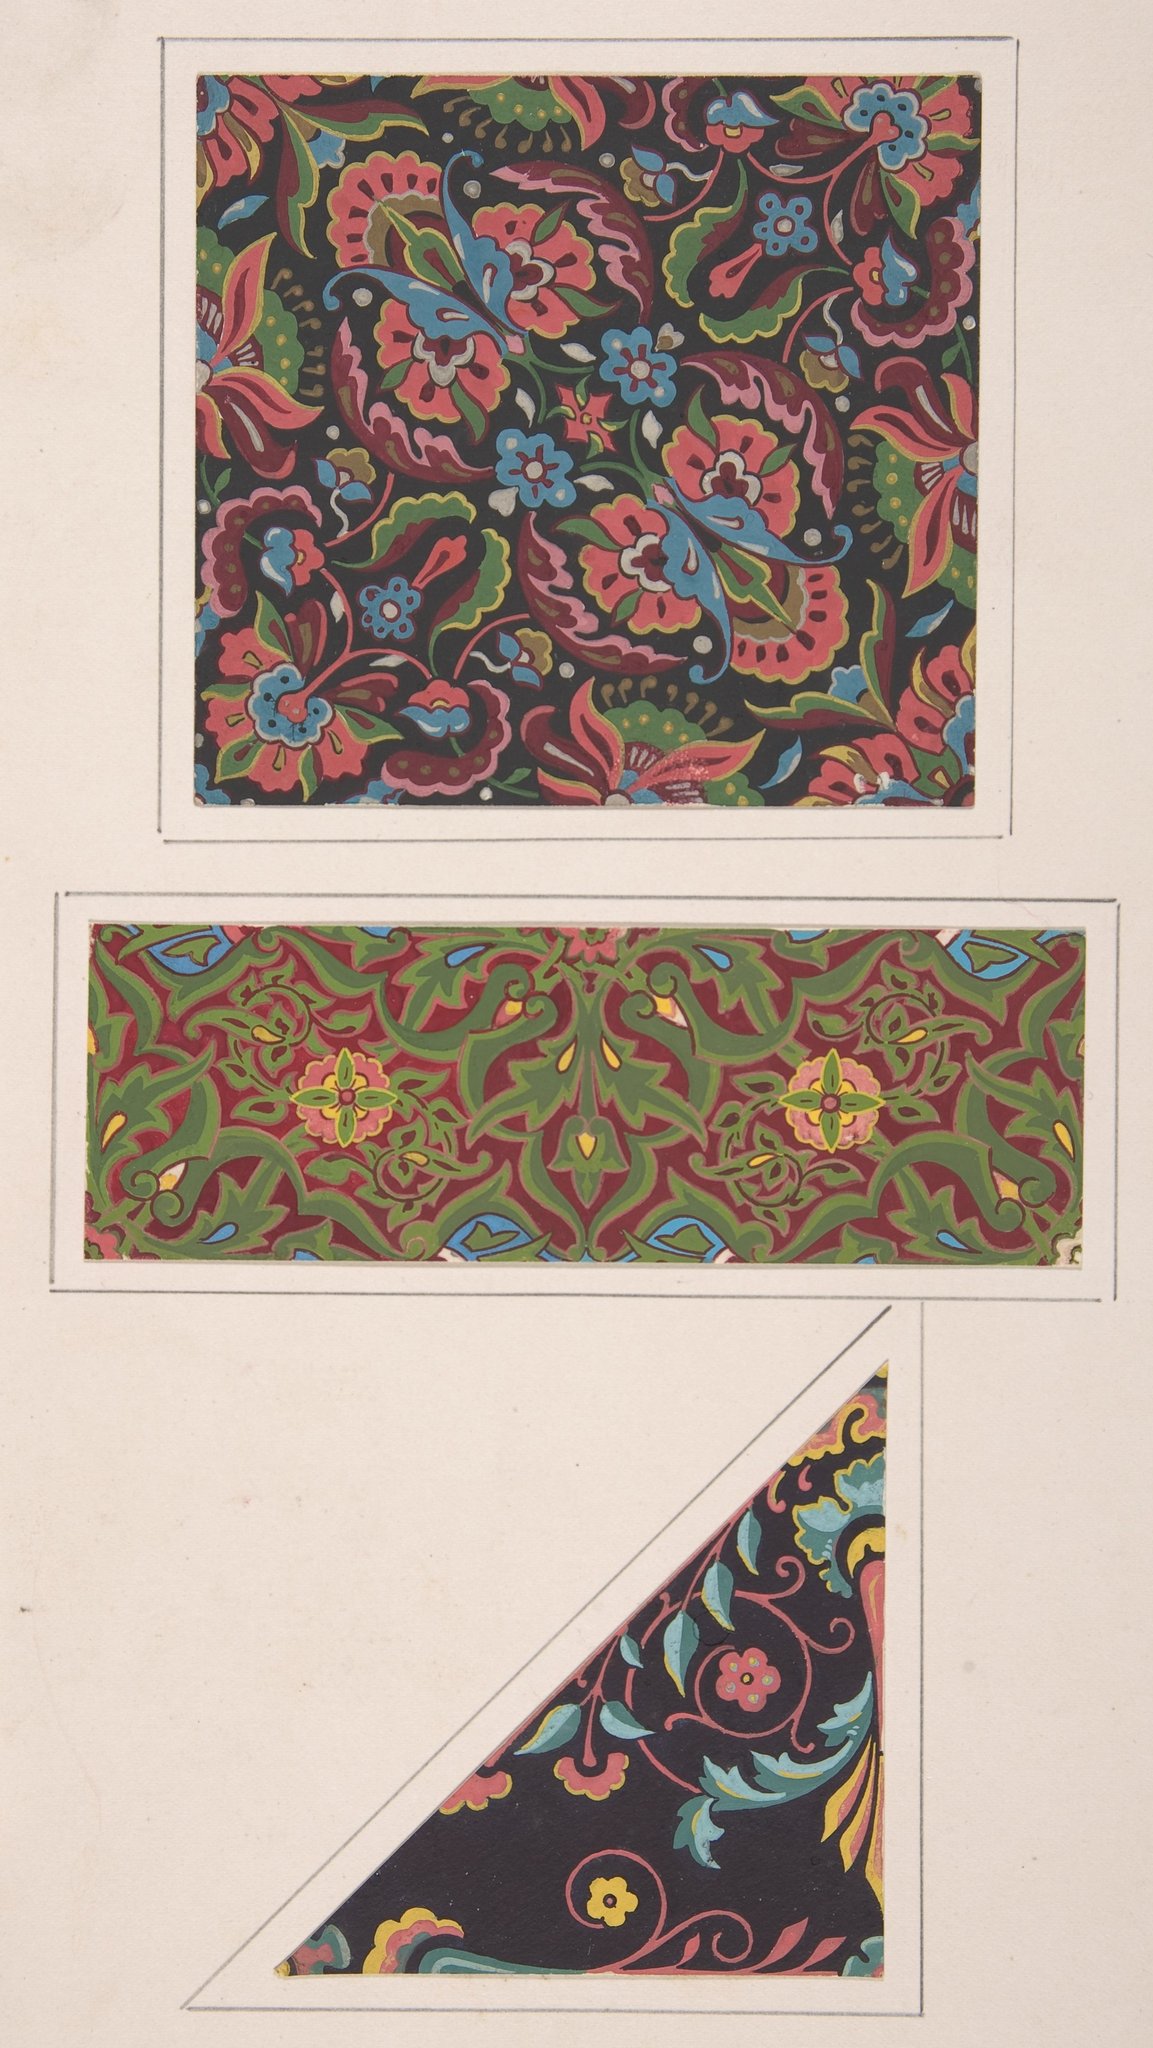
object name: drawing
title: Design drawing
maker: christopher dresser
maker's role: designer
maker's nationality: british, scottish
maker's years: 1834-1904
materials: gouache, graphite, ink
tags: flowers,leaves